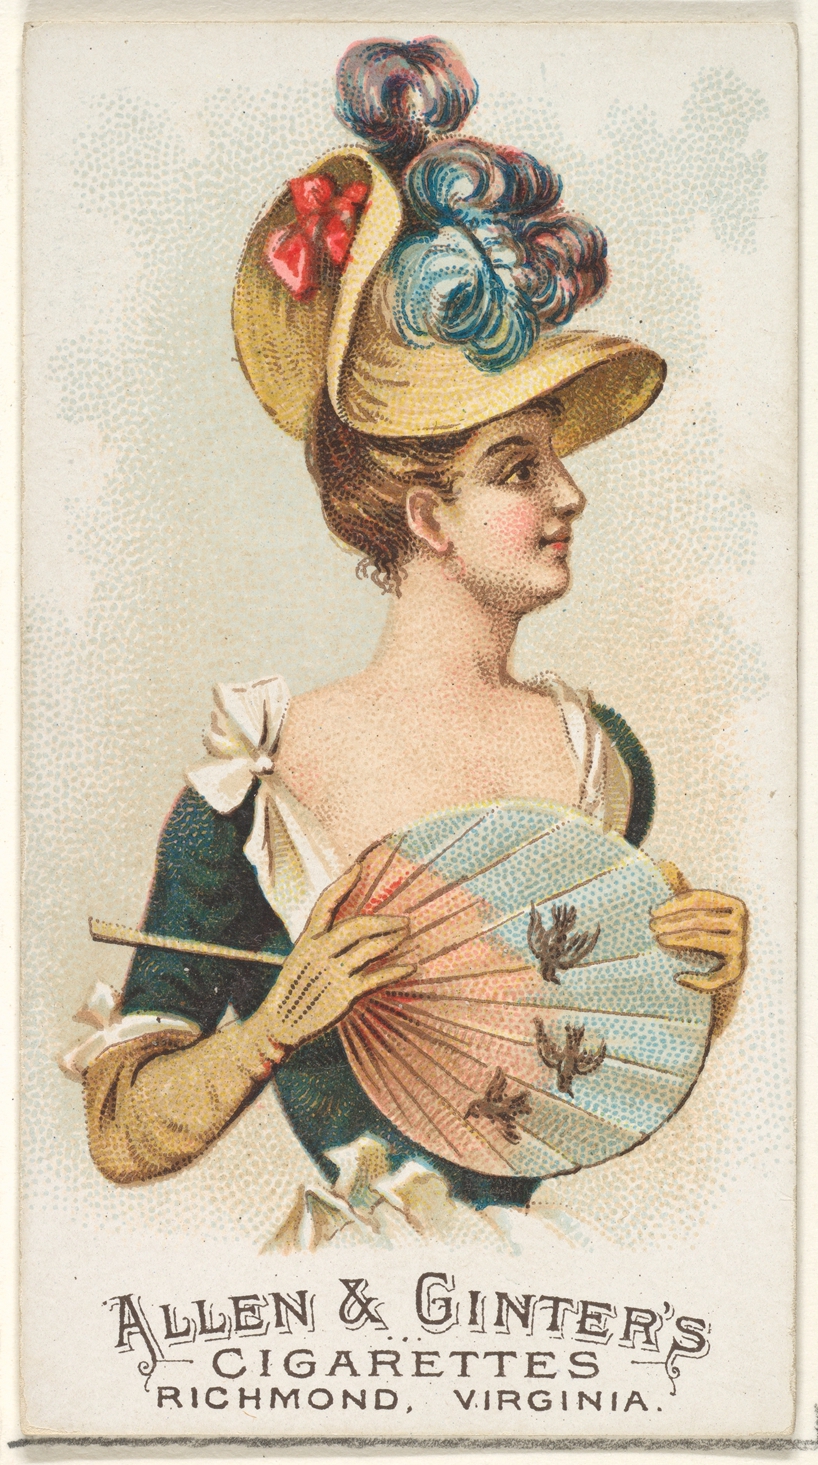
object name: print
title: Plate 25, from the Fans of the Period series (N7) for Allen & Ginter Cigarettes Brands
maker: allen & ginter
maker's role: publisher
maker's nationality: american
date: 1889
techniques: color lithograph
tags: birds,fans,women